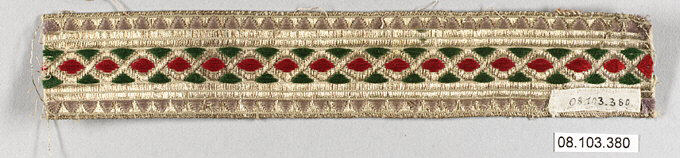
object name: galloon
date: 1601-1800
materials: metal thread, silk